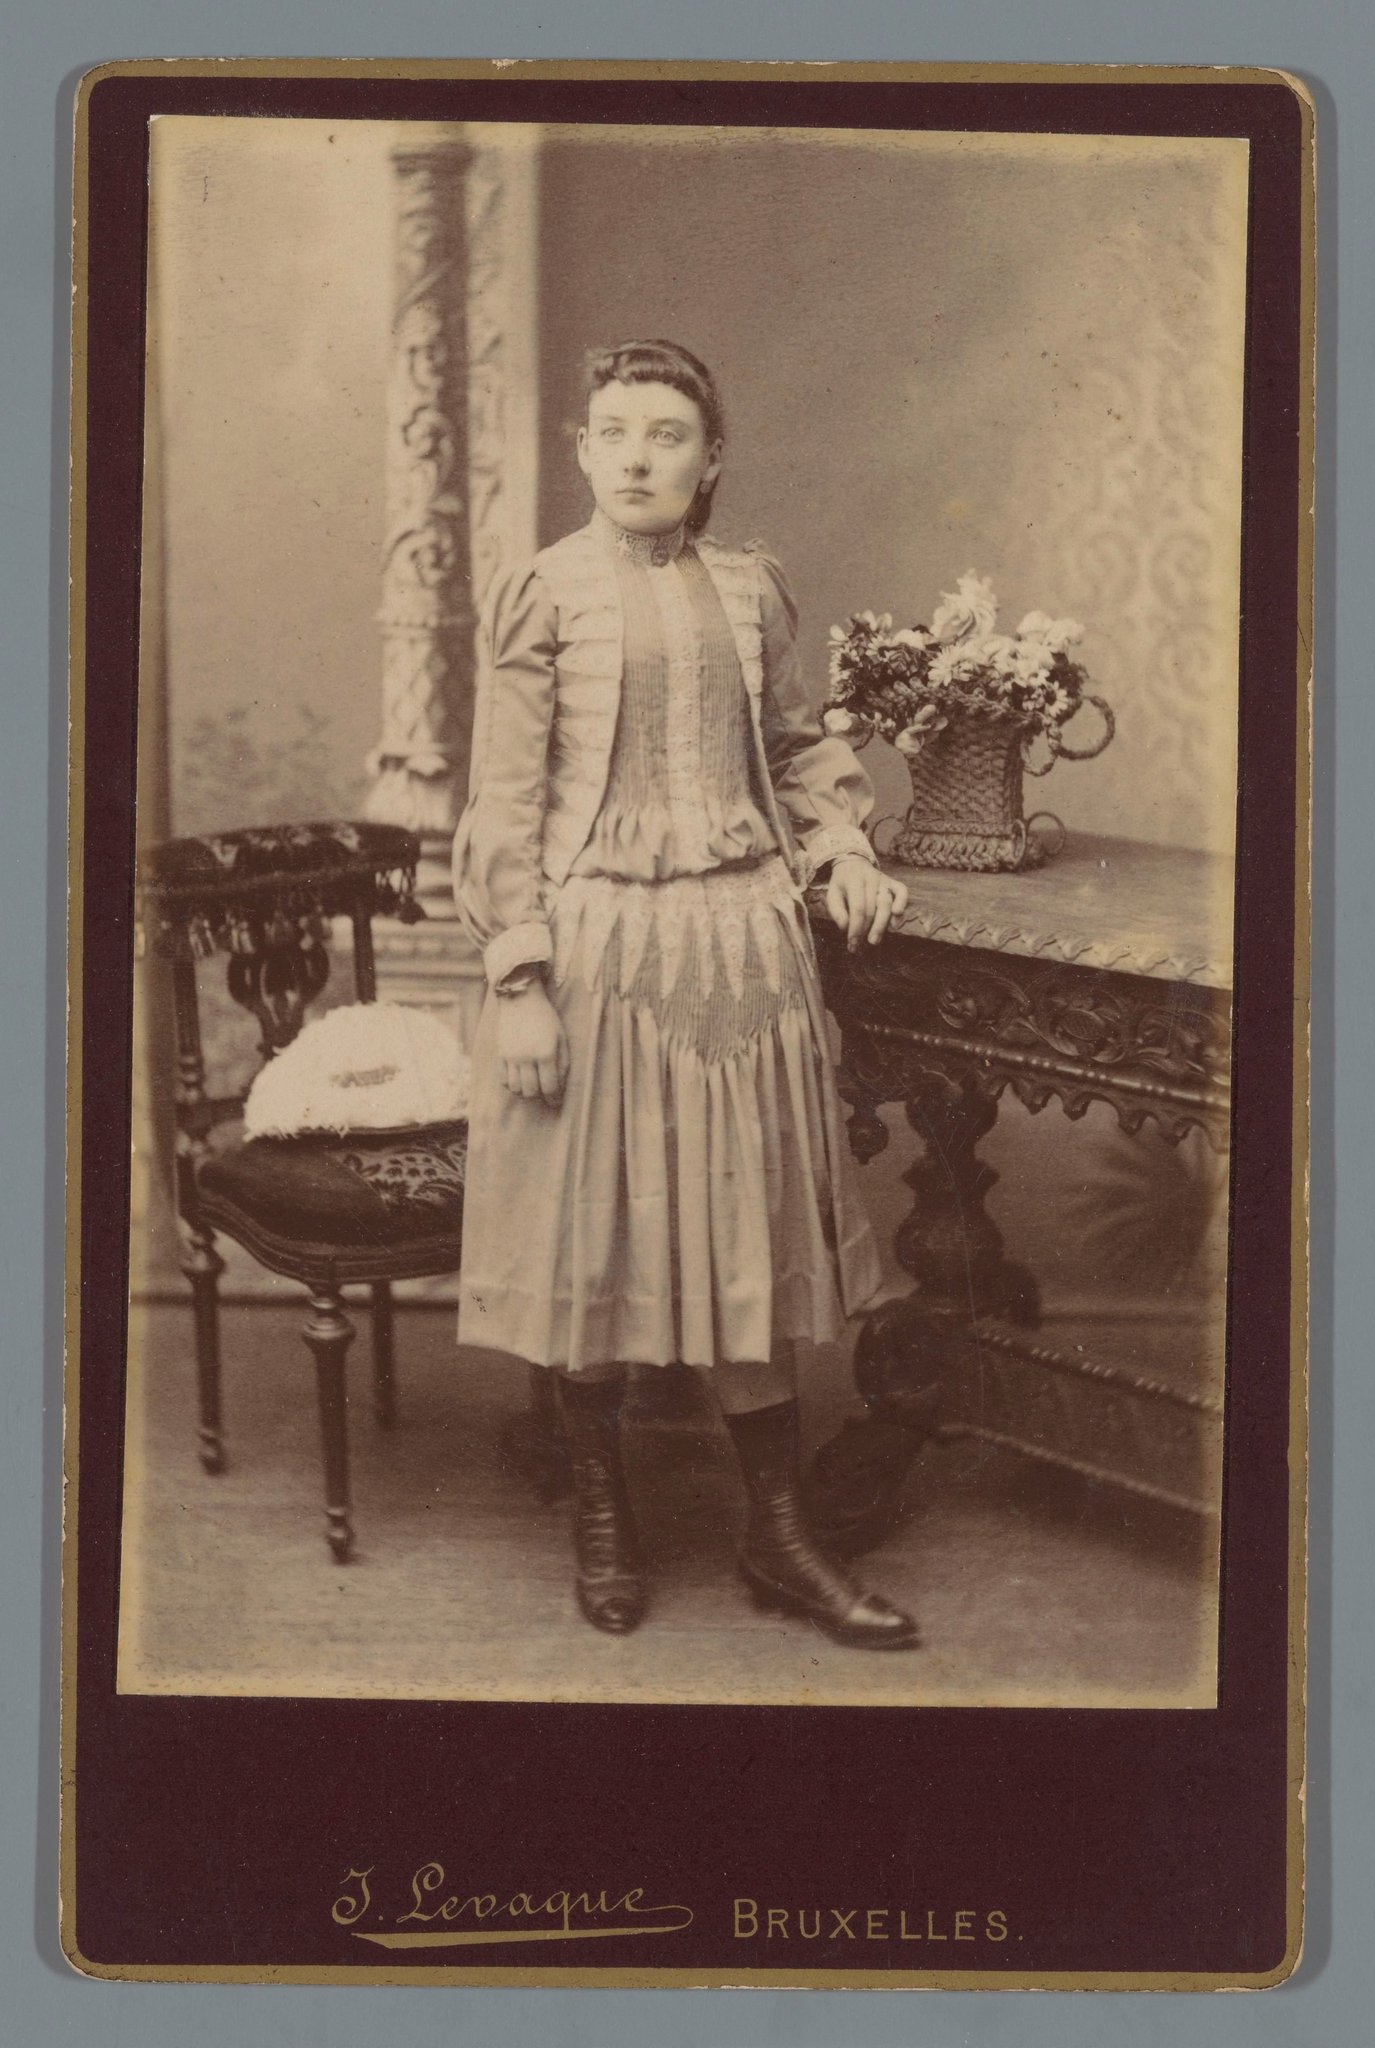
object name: cabinet photograph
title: Portret van een onbekend meisje naast een tafel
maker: jerôme levaque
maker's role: fotograaf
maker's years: 1852-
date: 1875-1899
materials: cardboard, photographic support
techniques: albumen print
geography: brussels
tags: adolescent, young woman, maiden, studio requisites ~ photographer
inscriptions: name: ‘J. Levaque Grande Photographie Américaine Bruxelles 72, Rue Neuve. (...)’